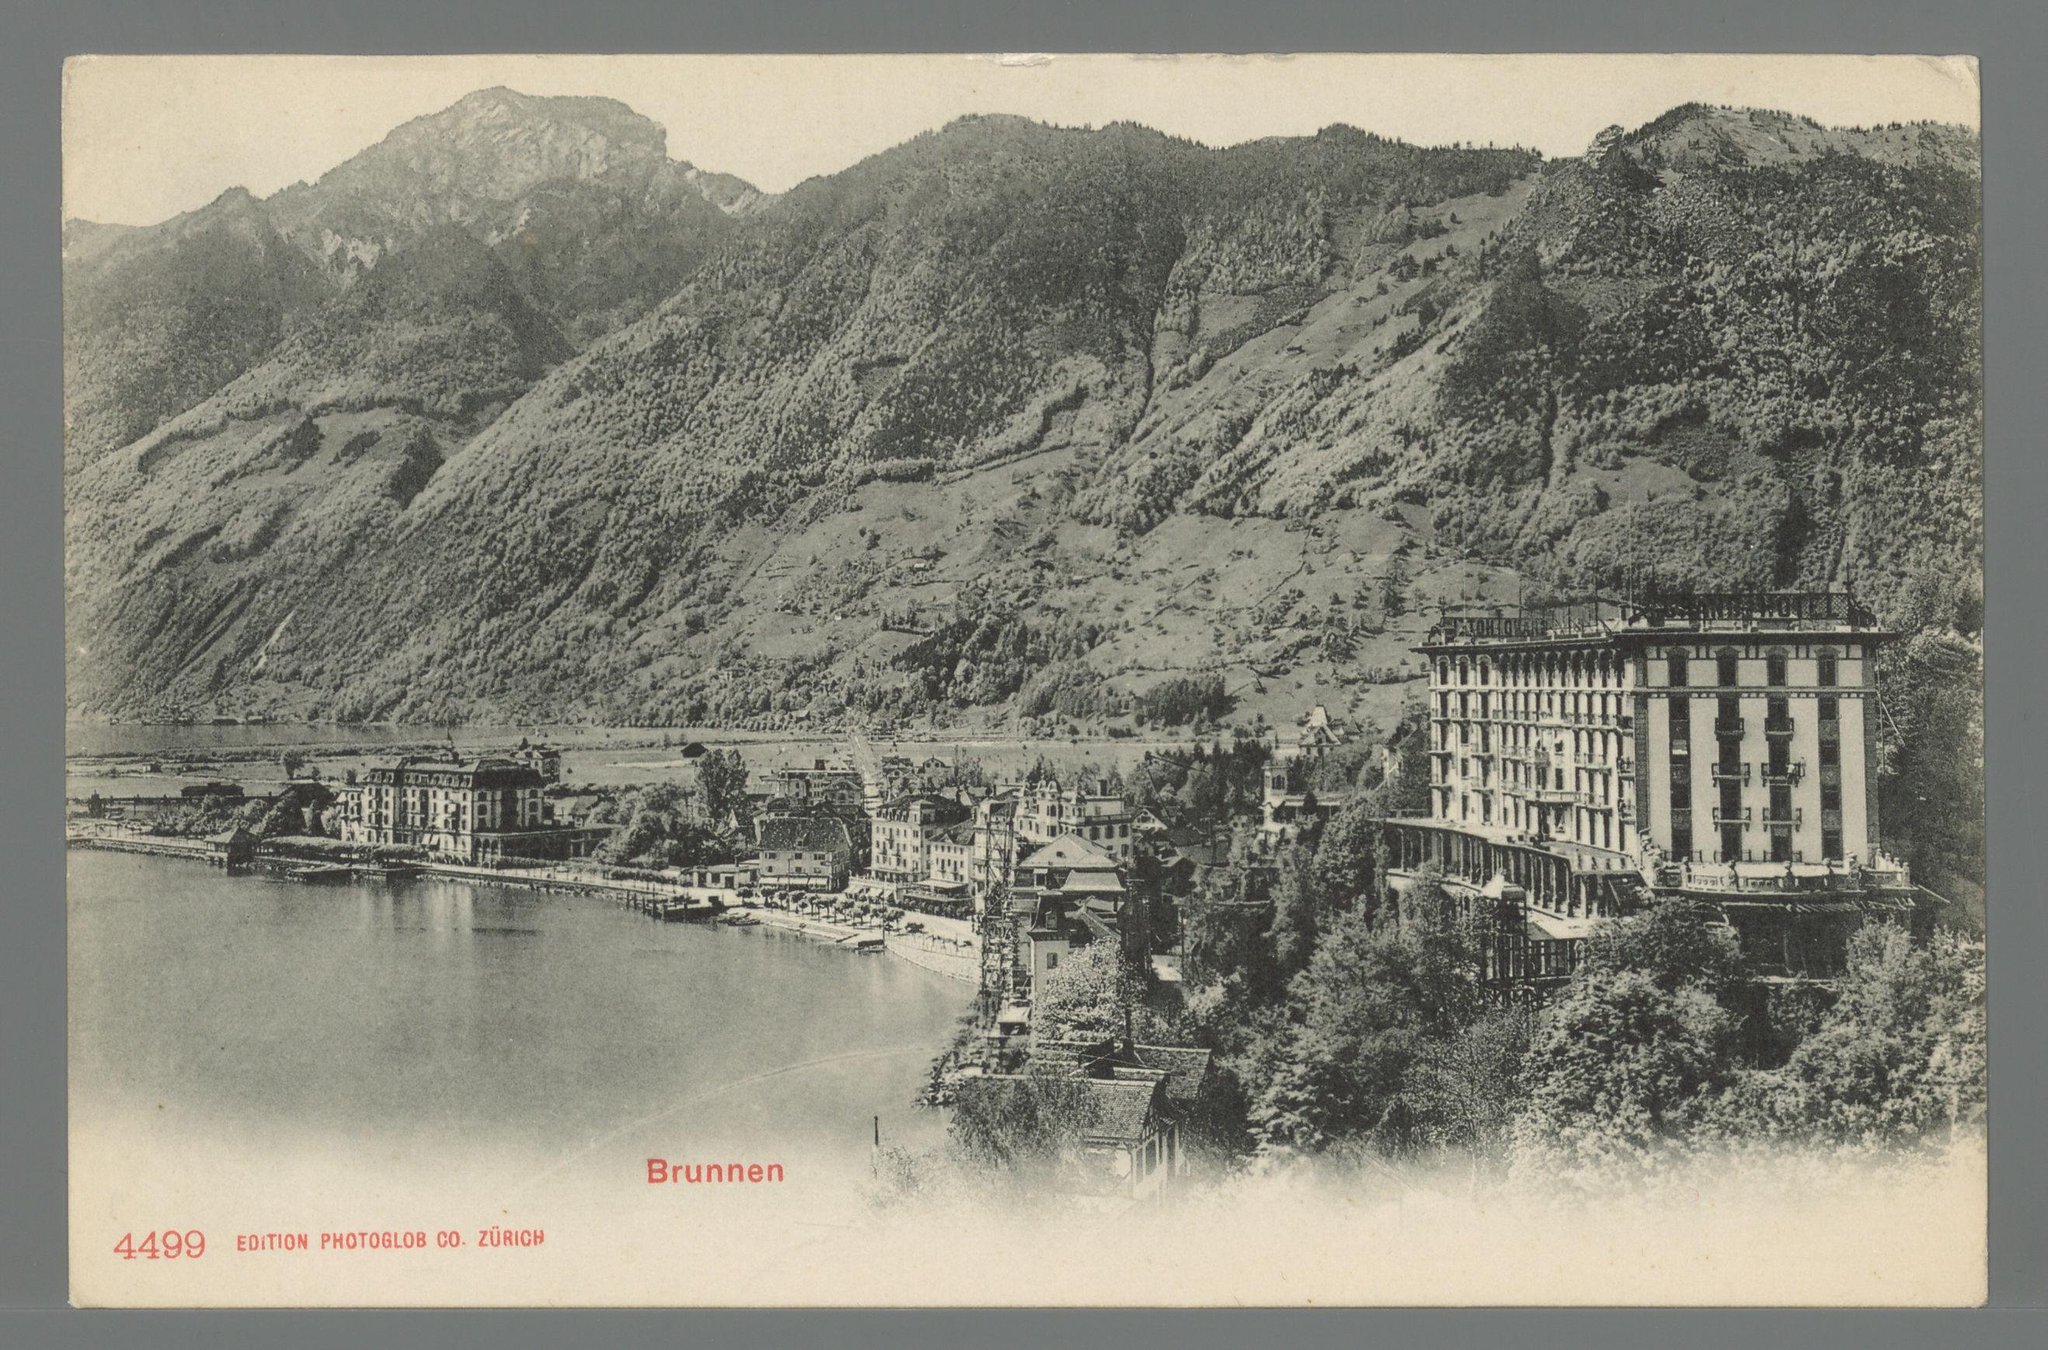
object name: ansichtkaart, prentbriefkaart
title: Brunnen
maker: Anonymous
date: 1905-1930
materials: cardboard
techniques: photograph, writing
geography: brunnen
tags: prospect of village, silhouette of village, lake, mountains (+ landscape with figures, staffage)